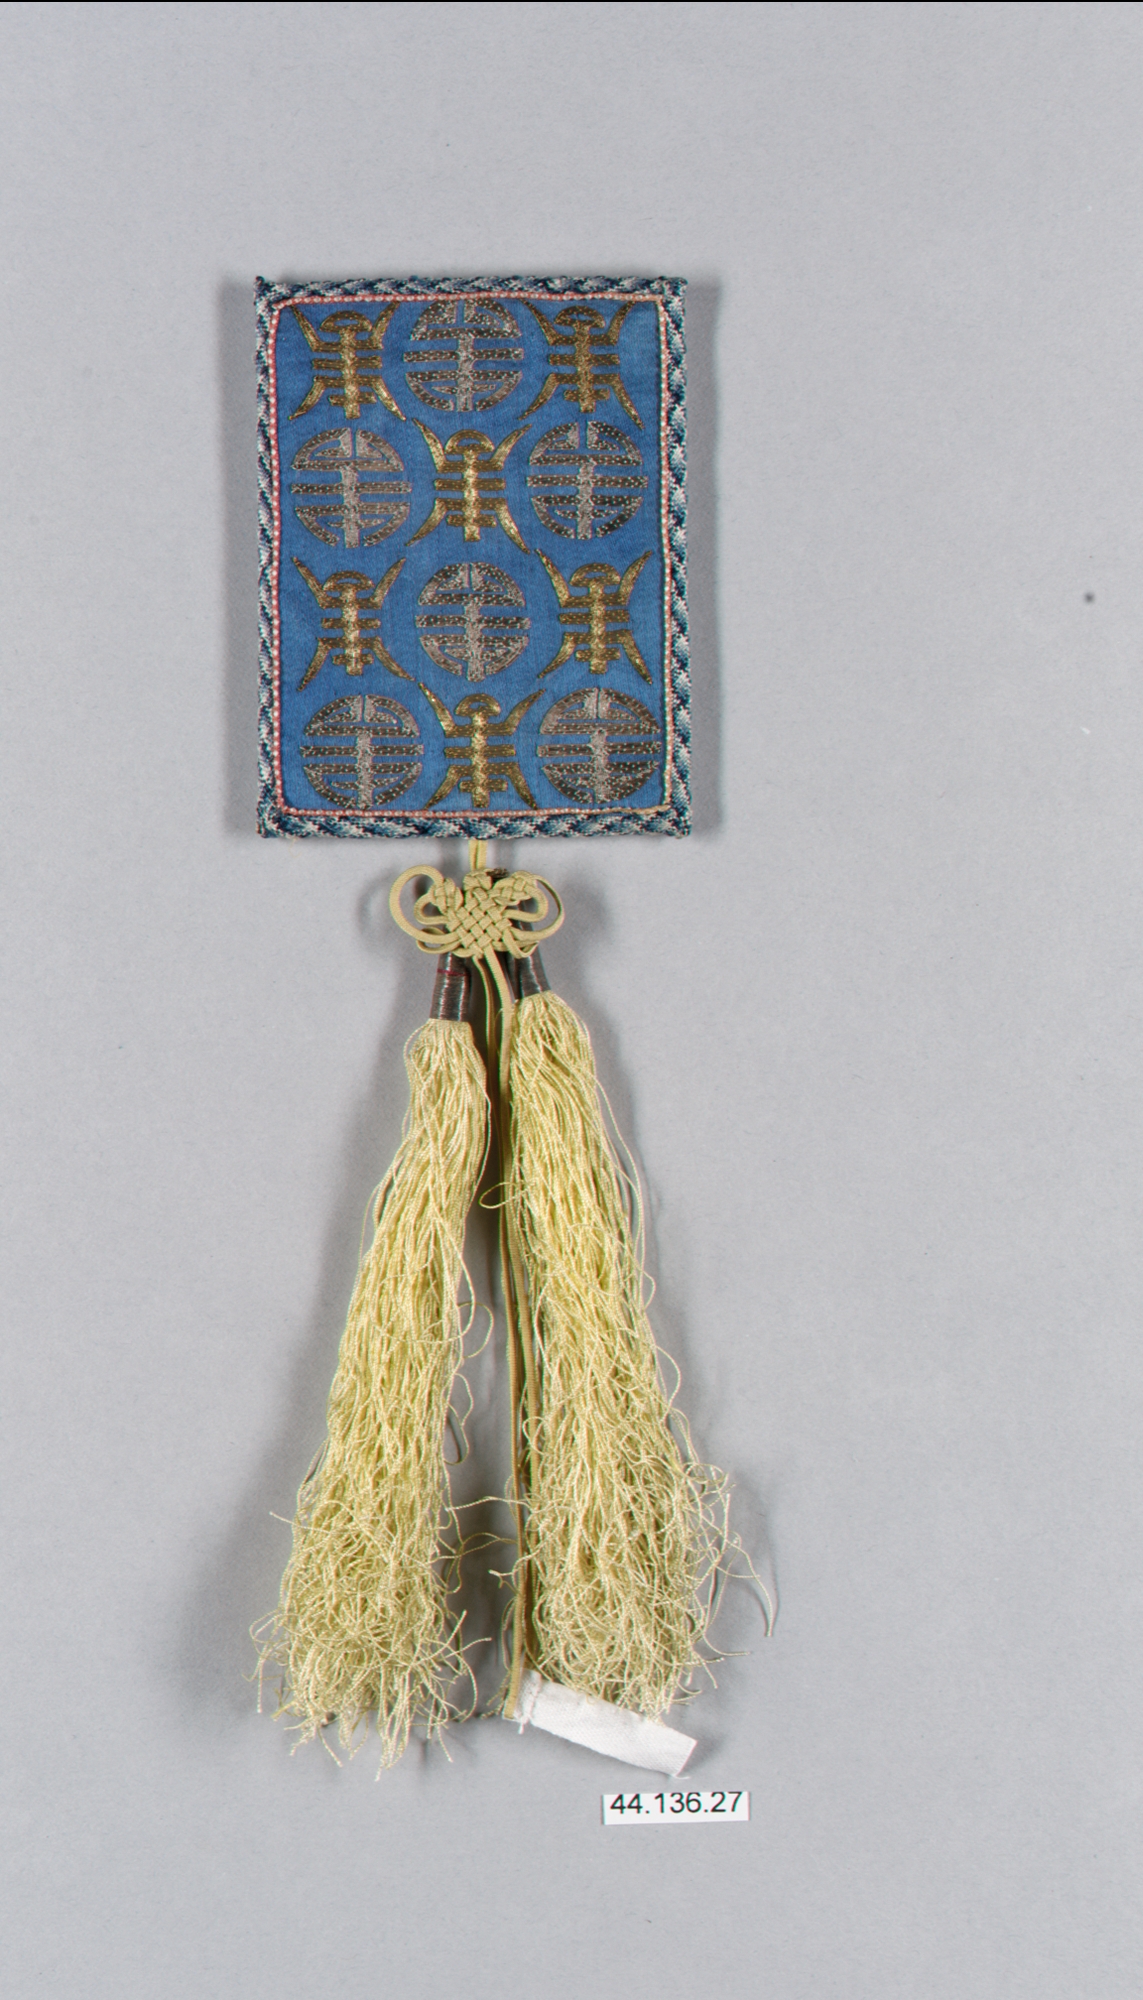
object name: mirror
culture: chinese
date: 1801-1900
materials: glass, metal thread, silk